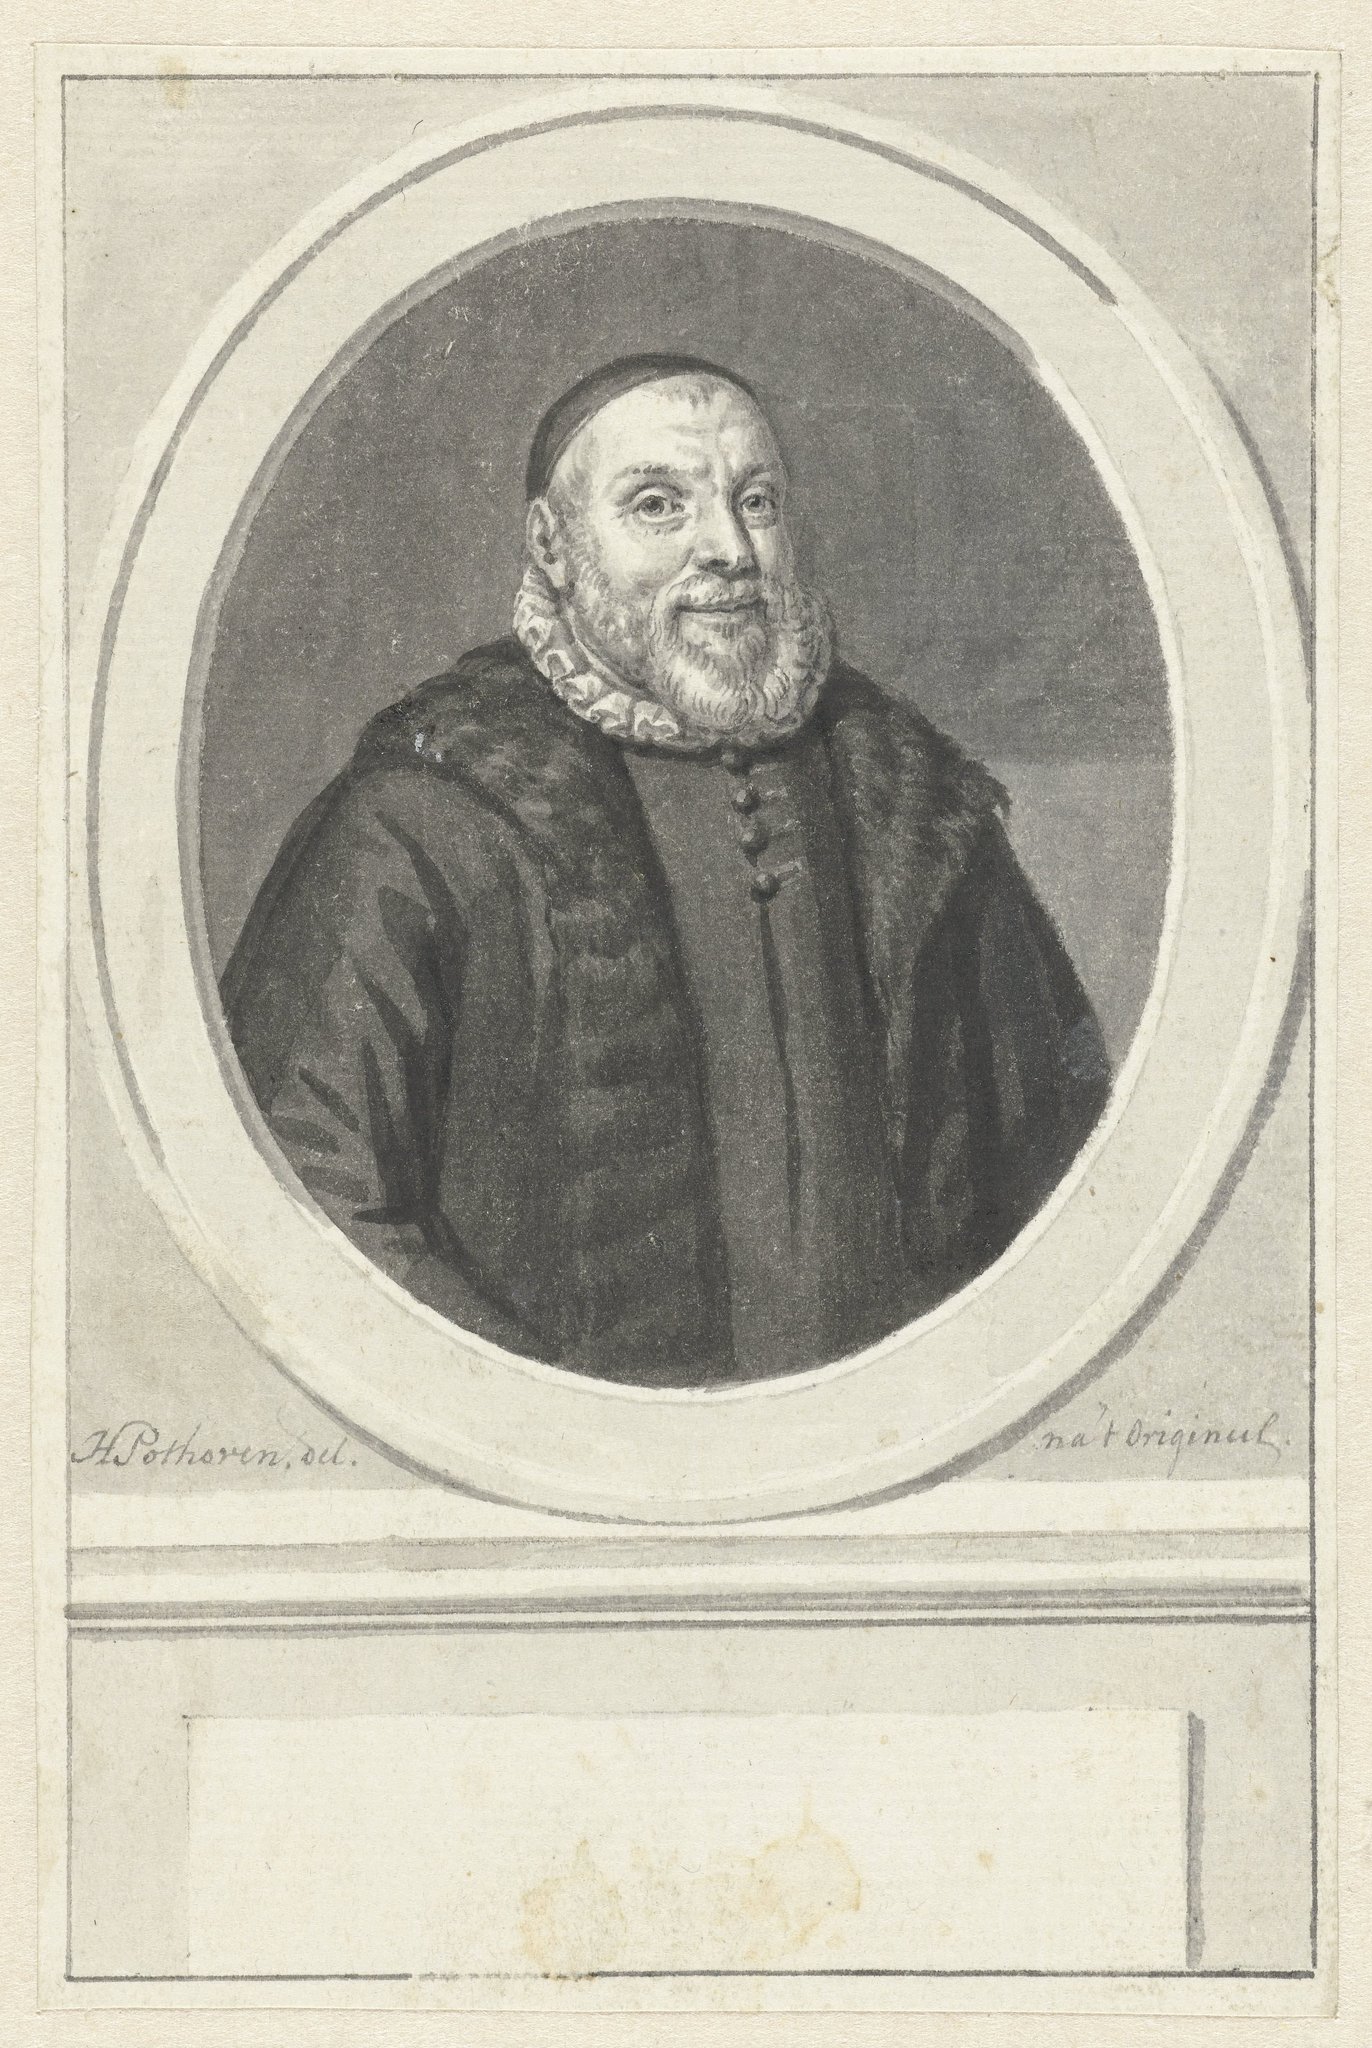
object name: design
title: Portret van Johannes Cuchlinus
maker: hendrik pothoven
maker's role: draughtsman, painter, print maker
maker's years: 1725-1807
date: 1735-1807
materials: ink, paper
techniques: brush, pen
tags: leiden, historical persons